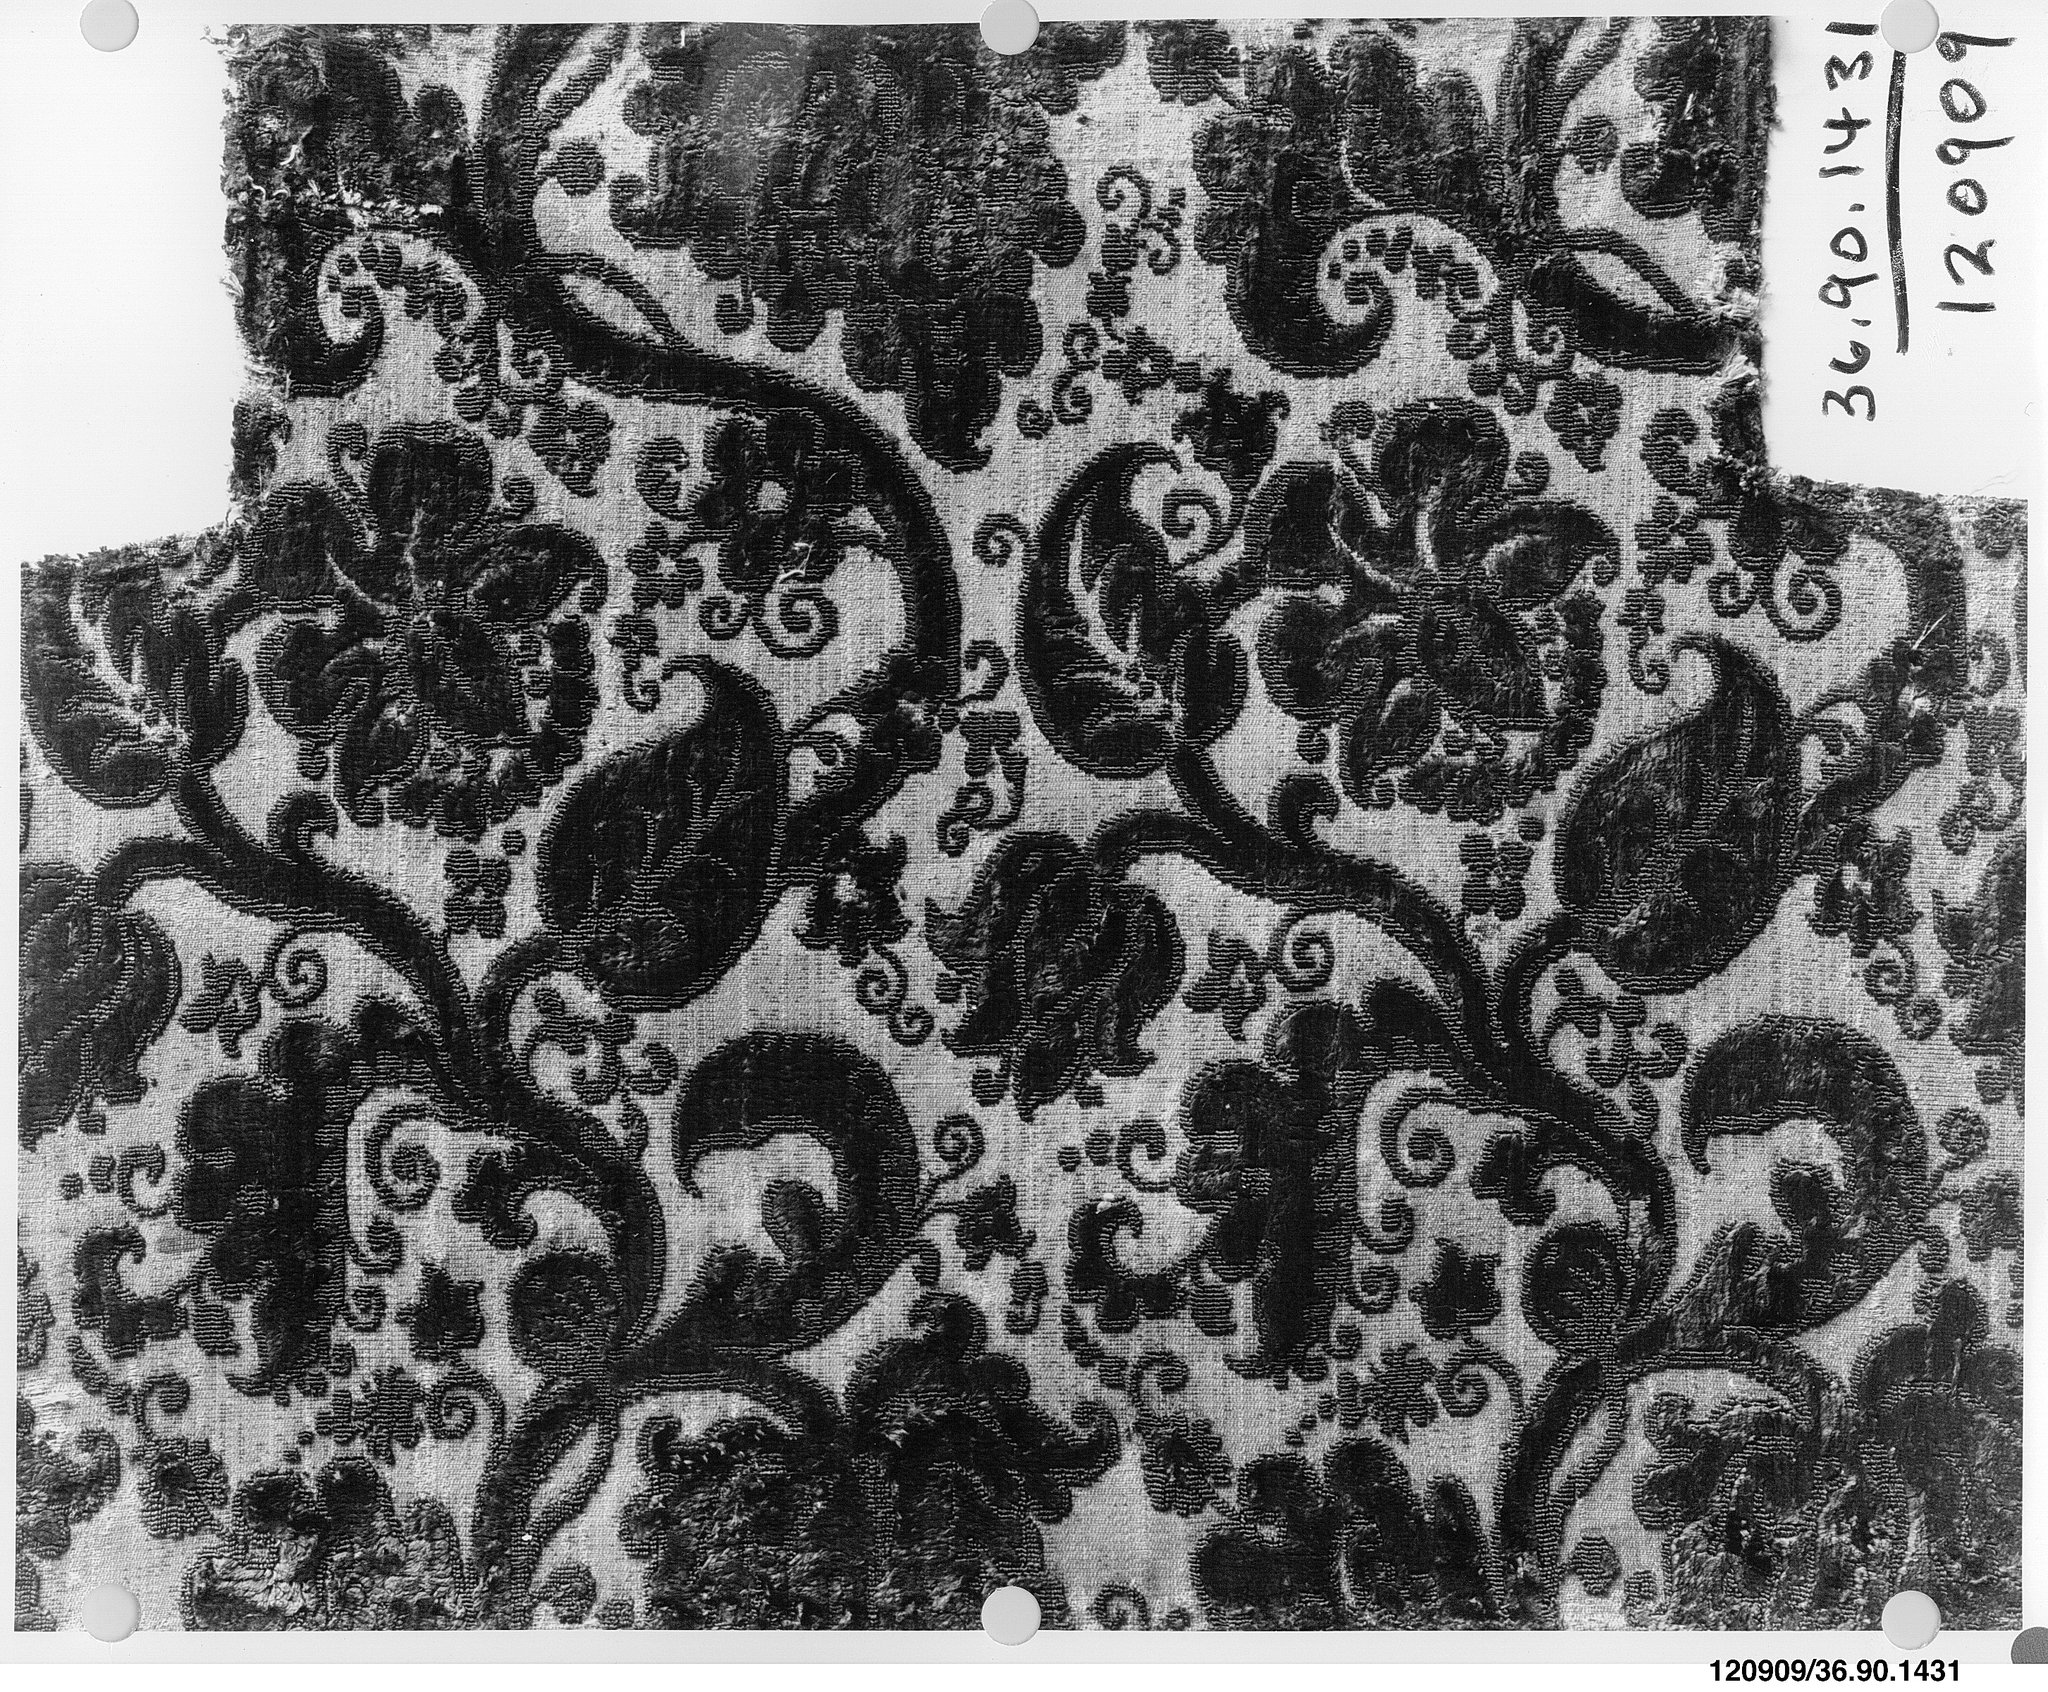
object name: piece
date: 1601-1700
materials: metal thread, silk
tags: flowers,leaves